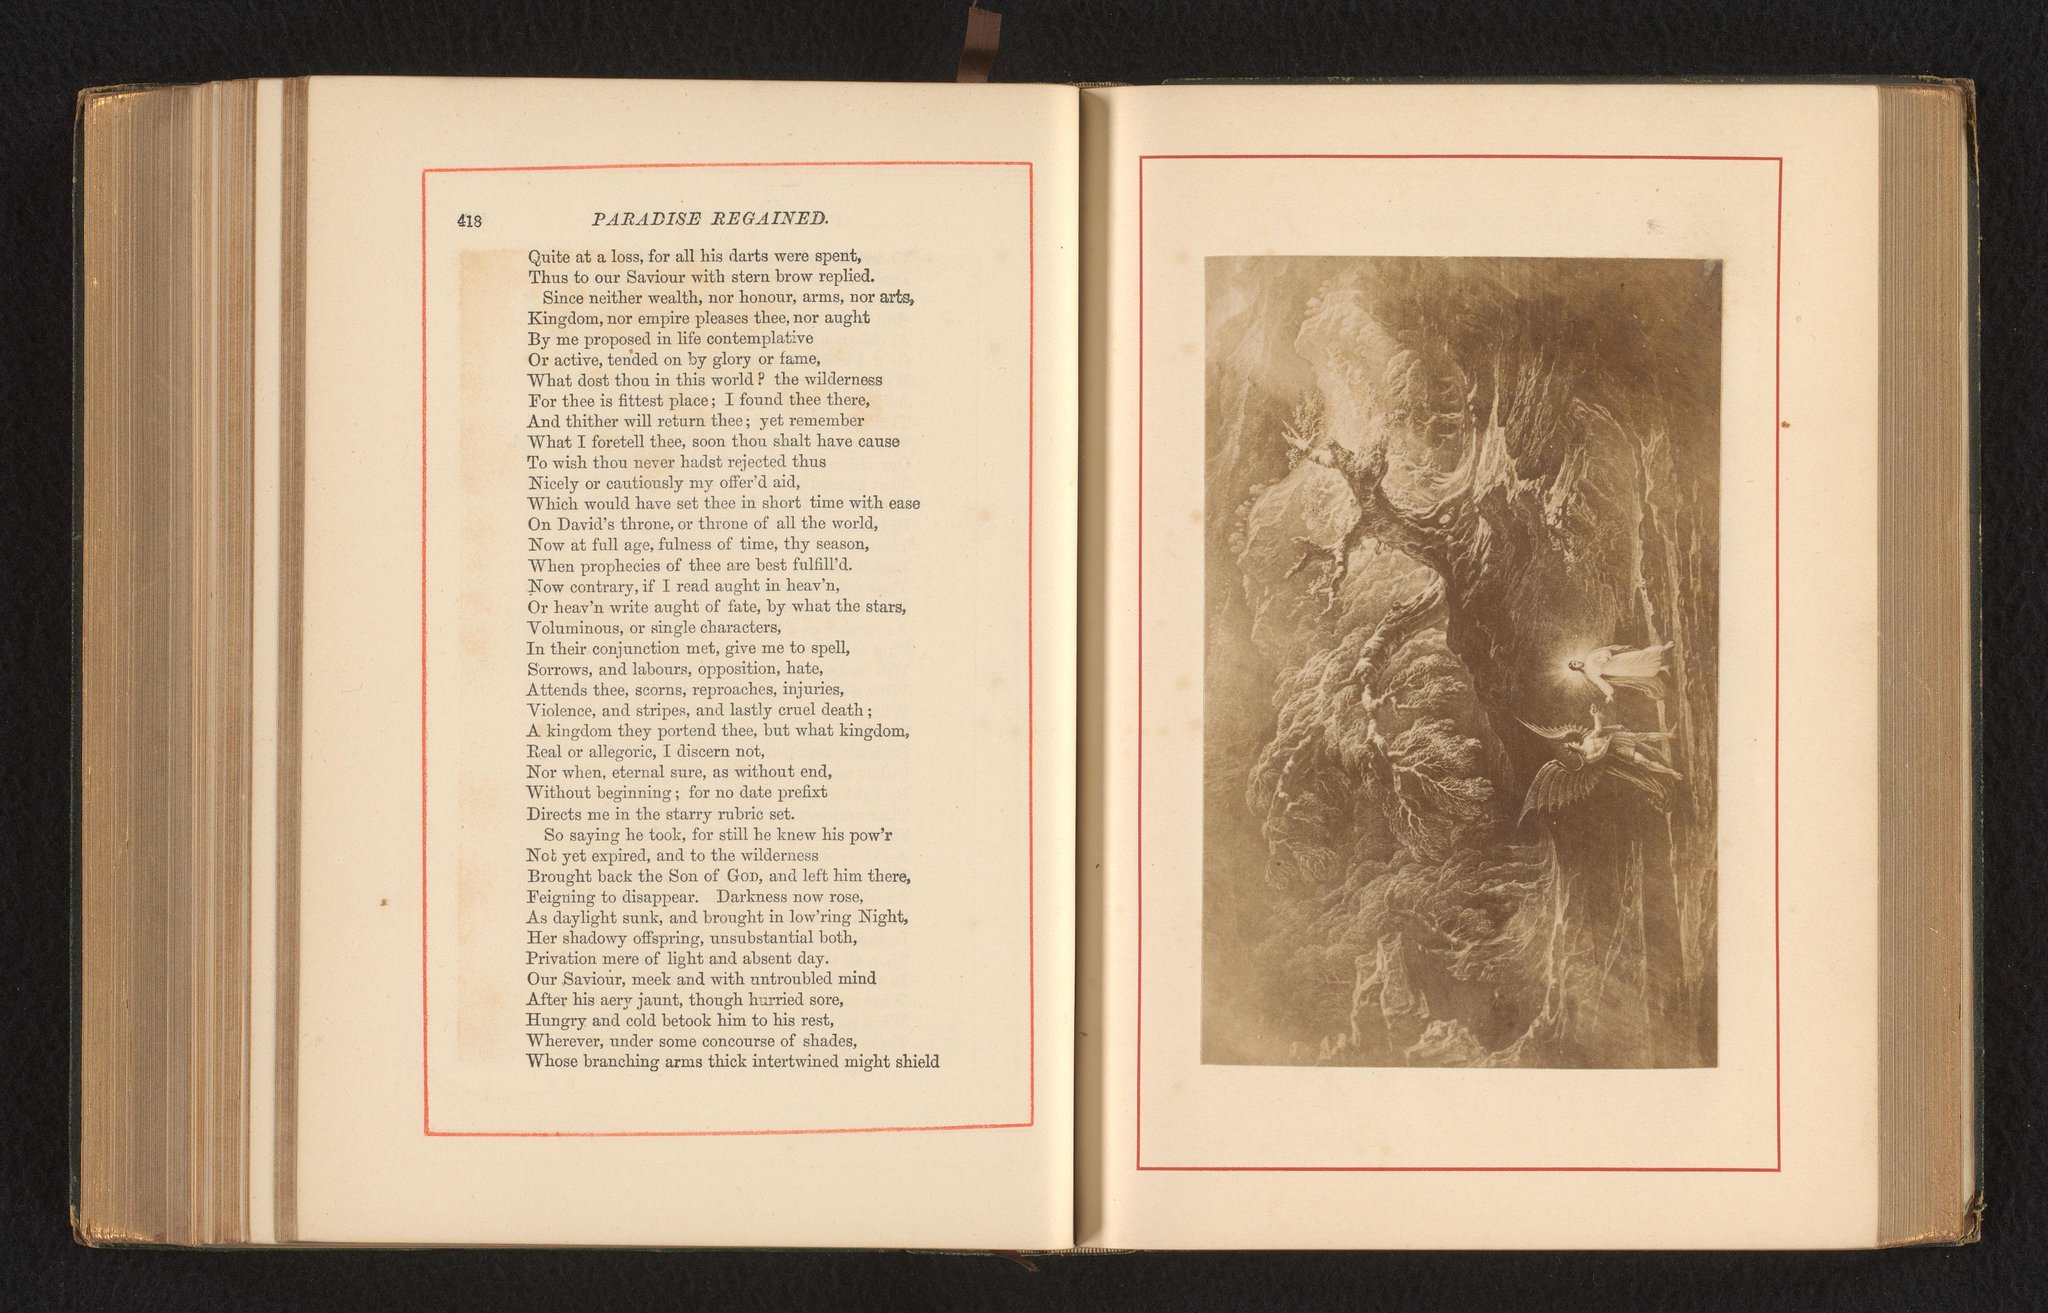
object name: page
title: Fotoreproductie van een schilderij van de Verzoeking van Christus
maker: Anonymous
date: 1866-1890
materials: paper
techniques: albumen print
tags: christ, sometimes accompanied by guardian angel(s), tempted by satan, who usually appears in human form, picture, painting